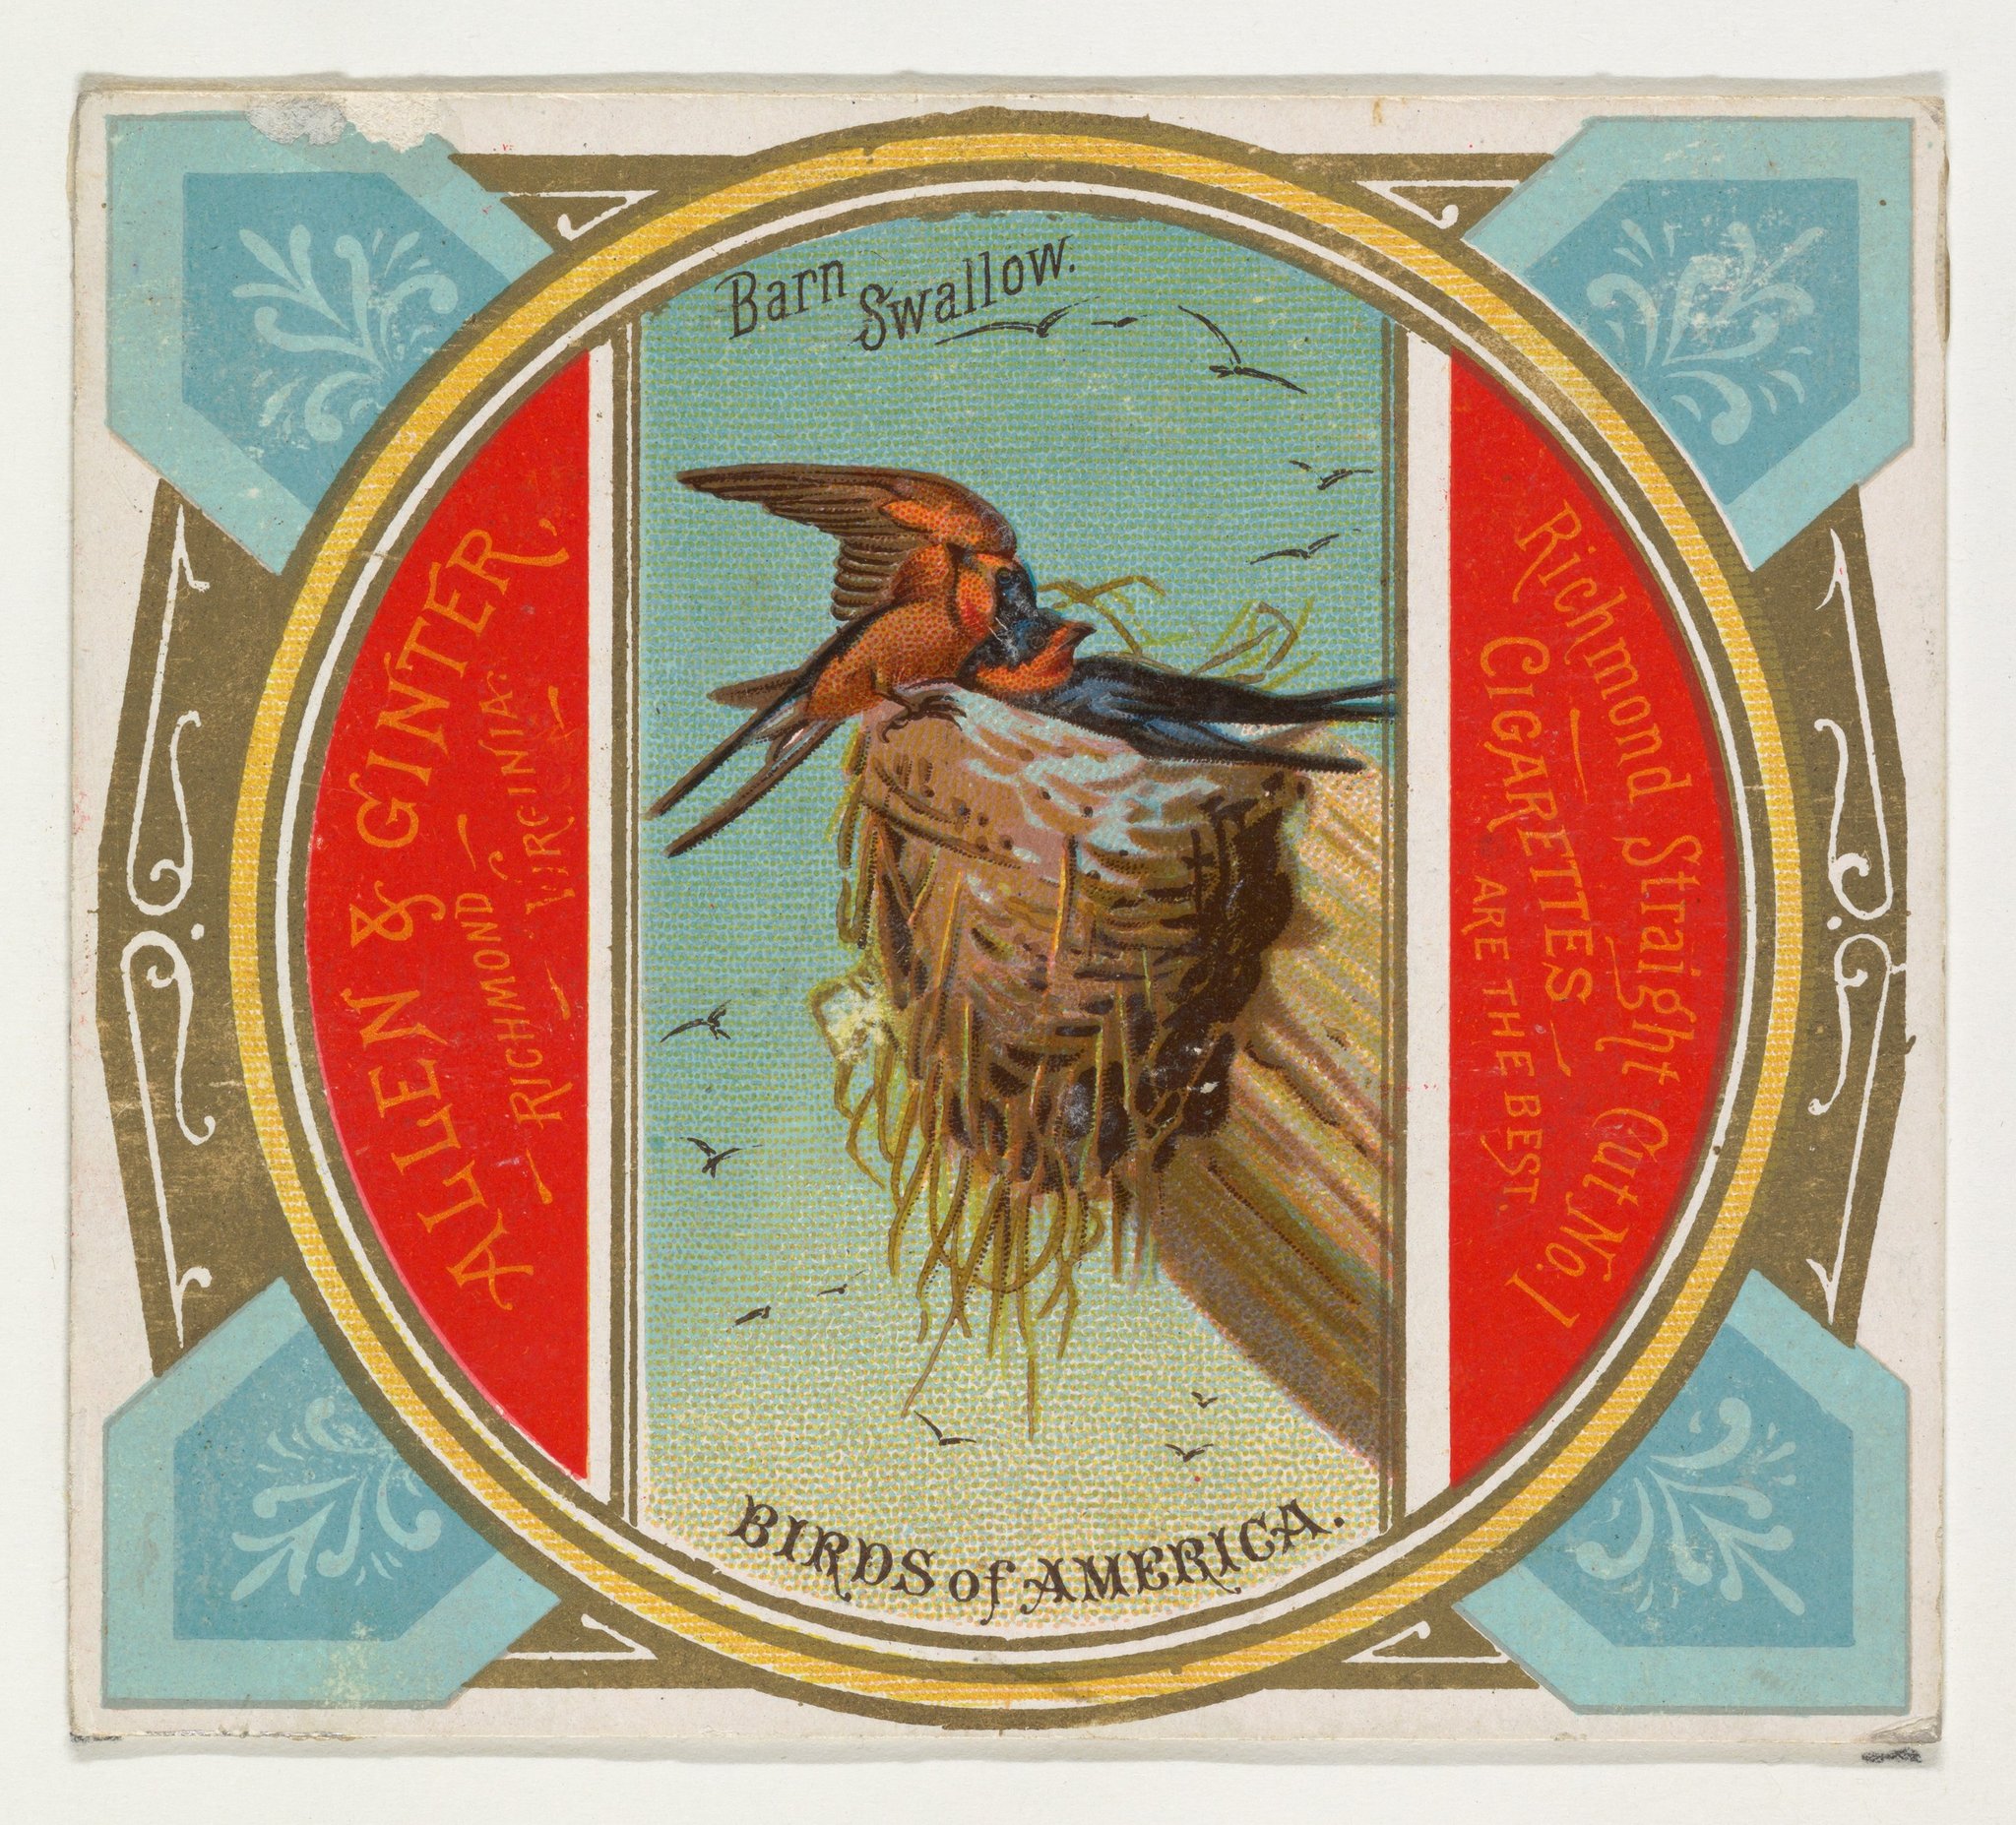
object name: print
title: Barn Swallow, from the Birds of America series (N37) for Allen & Ginter Cigarettes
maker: allen & ginter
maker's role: publisher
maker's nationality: american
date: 1888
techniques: color lithograph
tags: birds